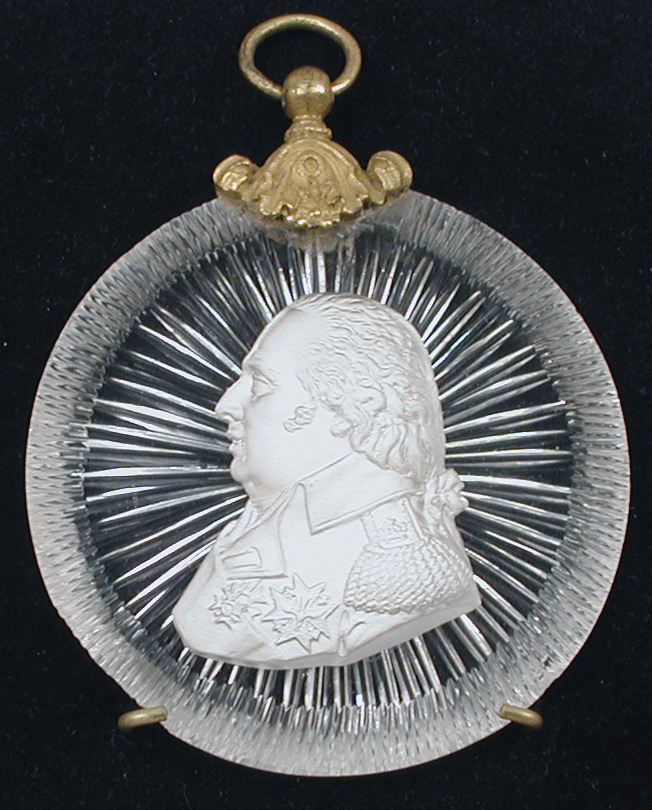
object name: medallion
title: Louis XVIII (1755–1824) wearing star of the Order of St. Esprit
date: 1815-1824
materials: ceramic, gilt bronze, glass, paste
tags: kings,profiles,stars